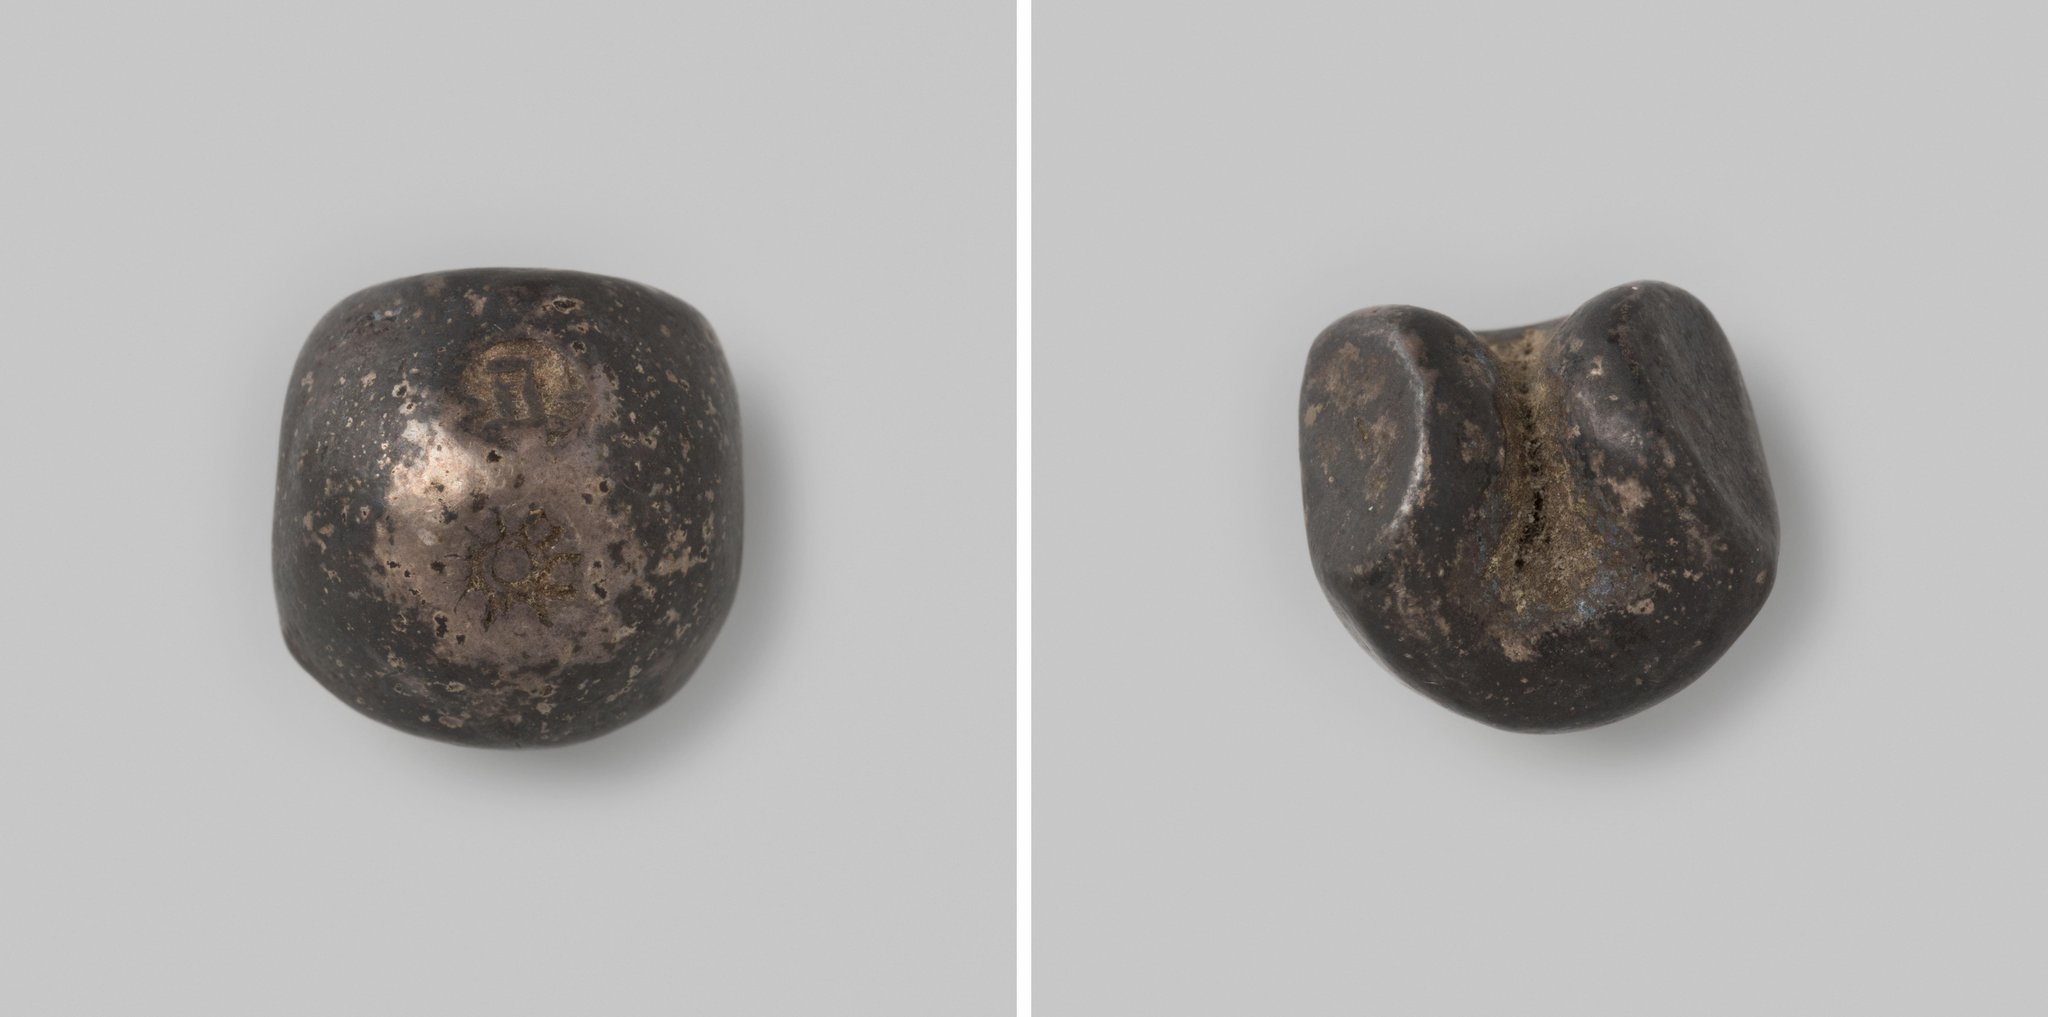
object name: coin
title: Thailand, tical, Nang KlaoTsjao,1824-1851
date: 1824-1851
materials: silver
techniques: casting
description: Zilveren, korrelvormige munt. voorzien van twee instempelingen (kra): rozet en boomblad [?].